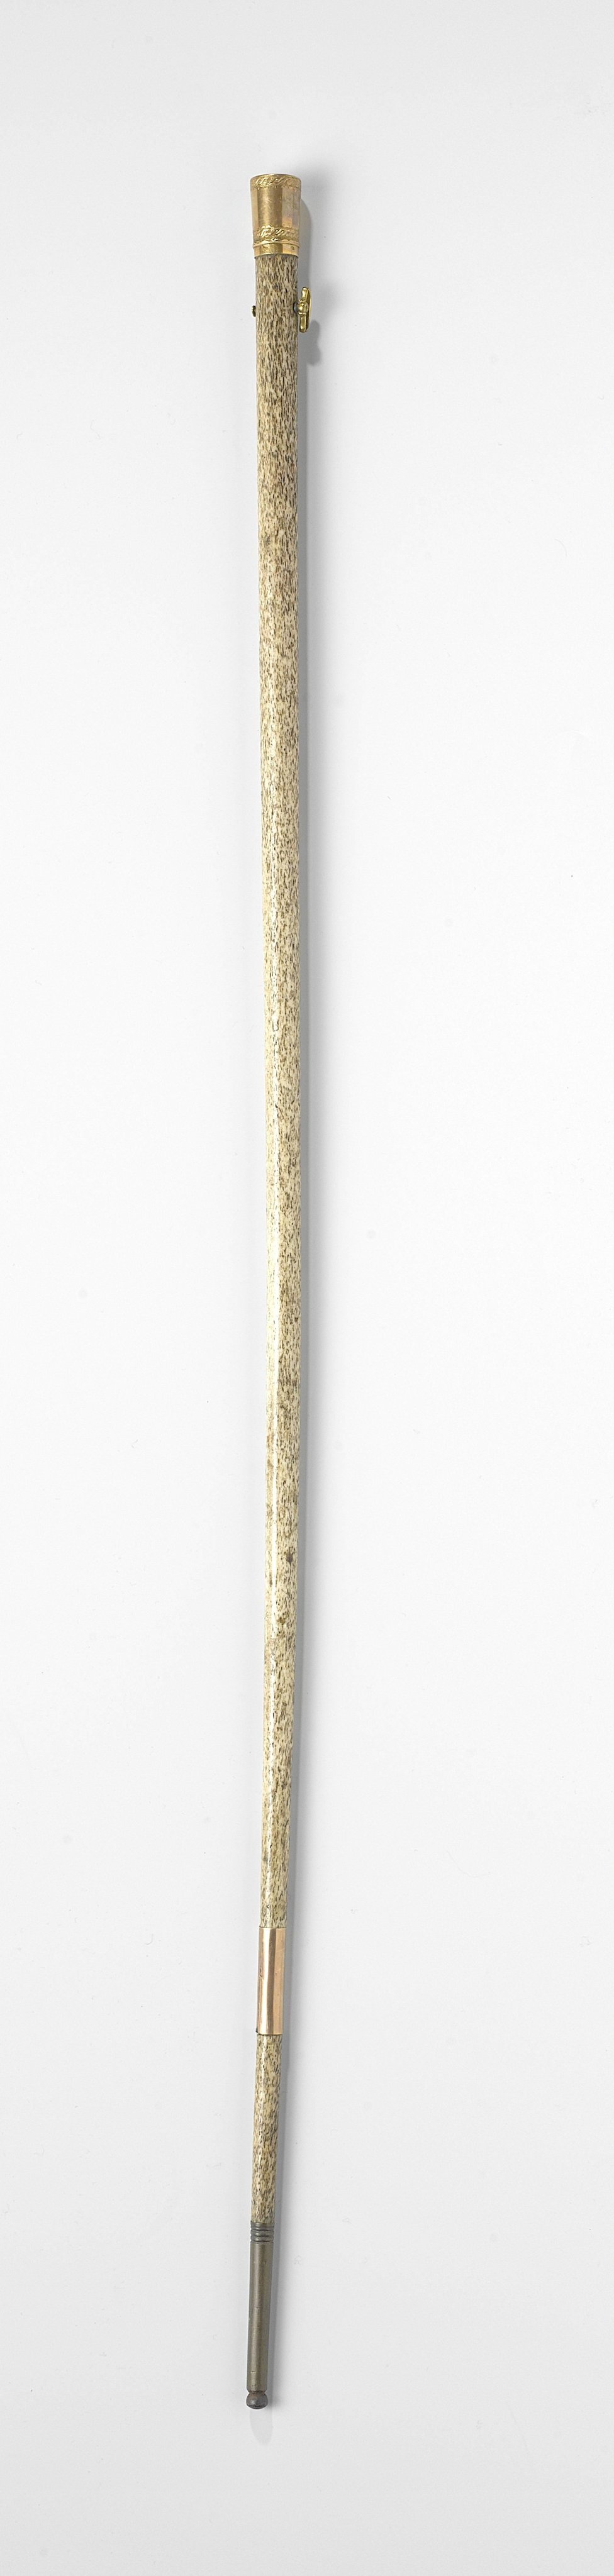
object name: walking stick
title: Stok van de tand van een narwal met een verguld koperen knop en oog, met koperen punt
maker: Anonymous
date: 1775-1800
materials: copper, pigment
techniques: fastening, gilding, striking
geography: netherlands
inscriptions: mark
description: De lange slagtand (tot 3 meter lang) van de 'Odontoceti' (tandwalvissen), die in een spiraal loopt is een typische eigenschap van de mannetjes. Het is in feite een uitgegroeide snijtand. [ B. du Mortier 2002]